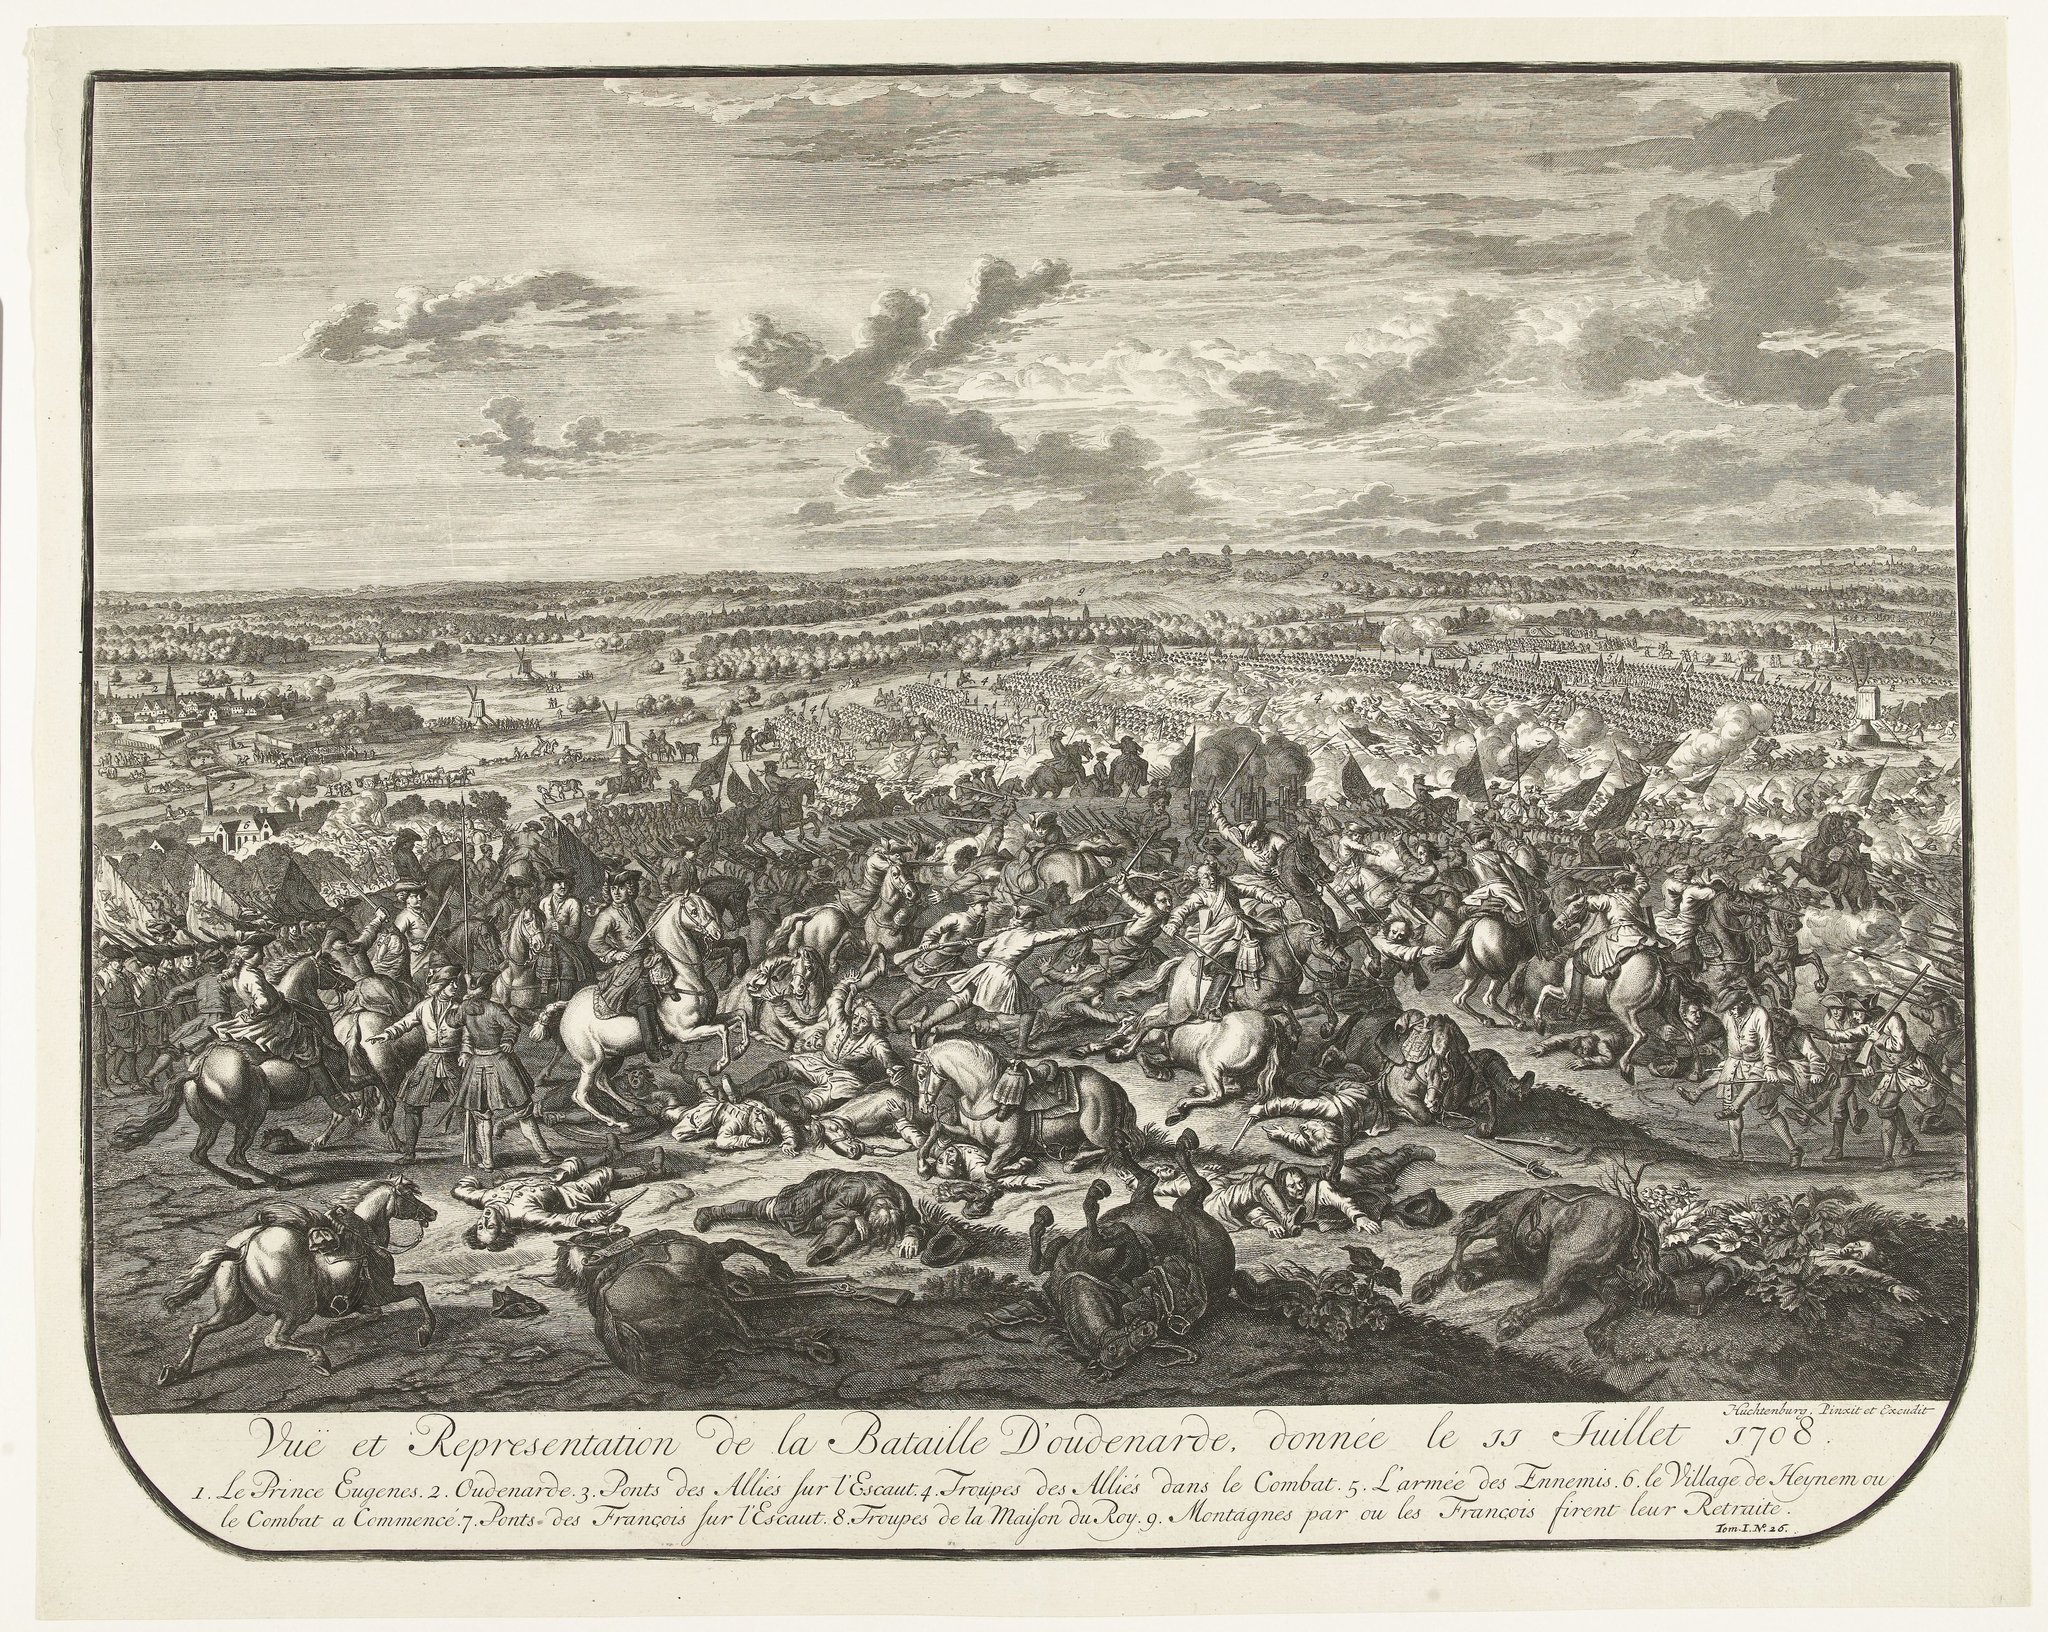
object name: history print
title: Vuë et Representation de la Bataille D'oudenarde, donnée le 11 Juillet 1708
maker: jan van huchtenburg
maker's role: draughtsman, painter, print maker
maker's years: 1647-1733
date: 1727-1729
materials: paper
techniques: engraving, etching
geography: northern netherlands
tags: paris, eugenius van savoye, battle (+ land forces)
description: In deze staat gebruikt als illustratie in het eerste deel van: Jean du Mont, Oorlogskundige beschryving van de veldslagen en belegeringen, der drie ... wydvermaarde krygsoversten... den Prins Eugenius van Savoye, den ... Hertog van Marlborough, en den Prins van Oranje en Nassau-Vriesland, in de editie van 1729.